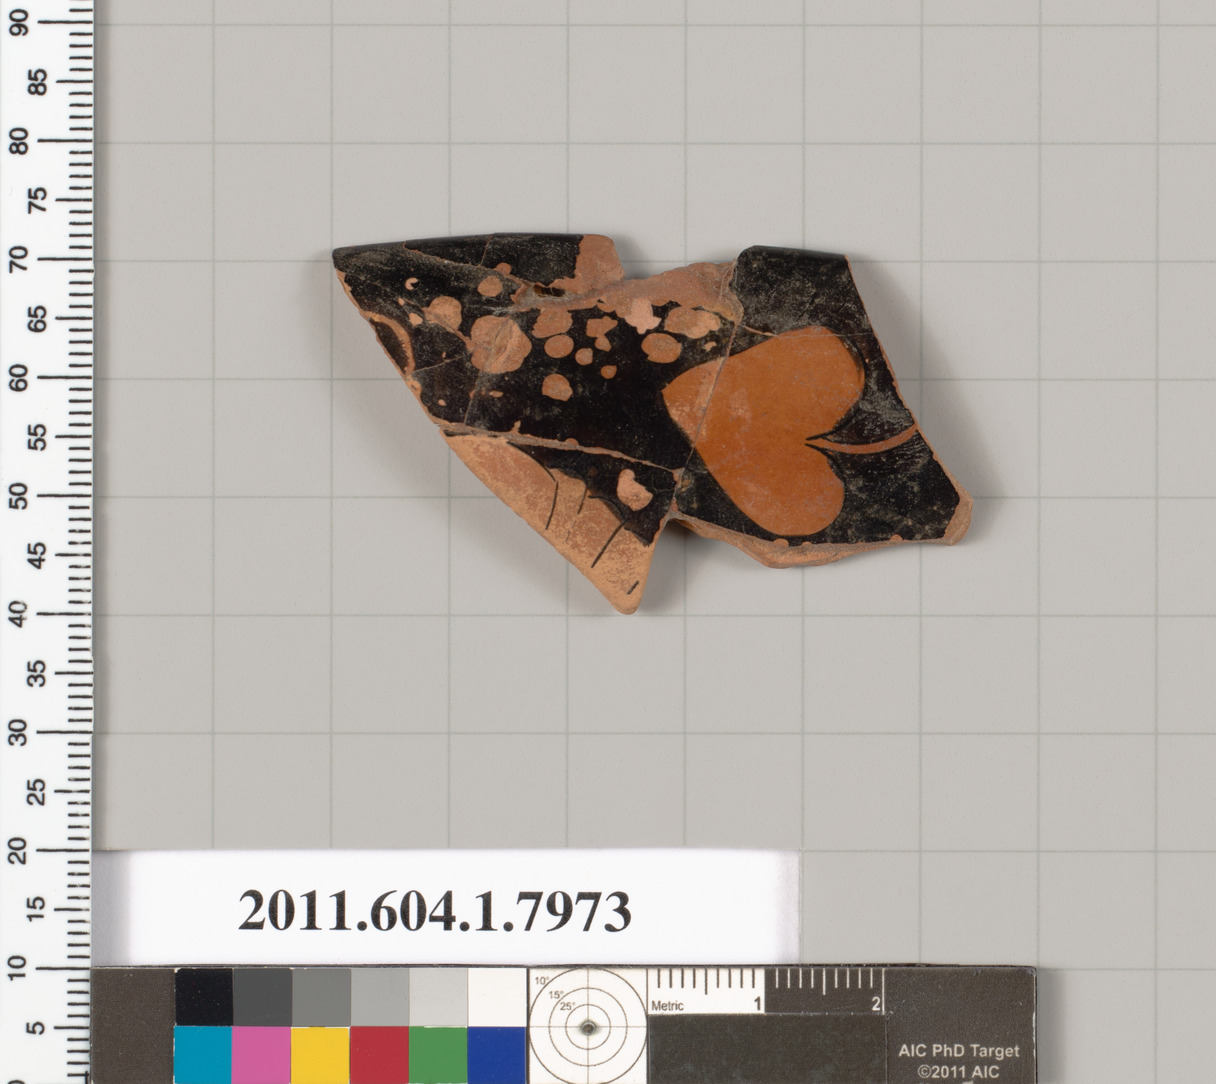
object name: kylix fragment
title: Terracotta rim fragment of a kylix (drinking cup)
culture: greek, attic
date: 460-450 BCE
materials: terracotta